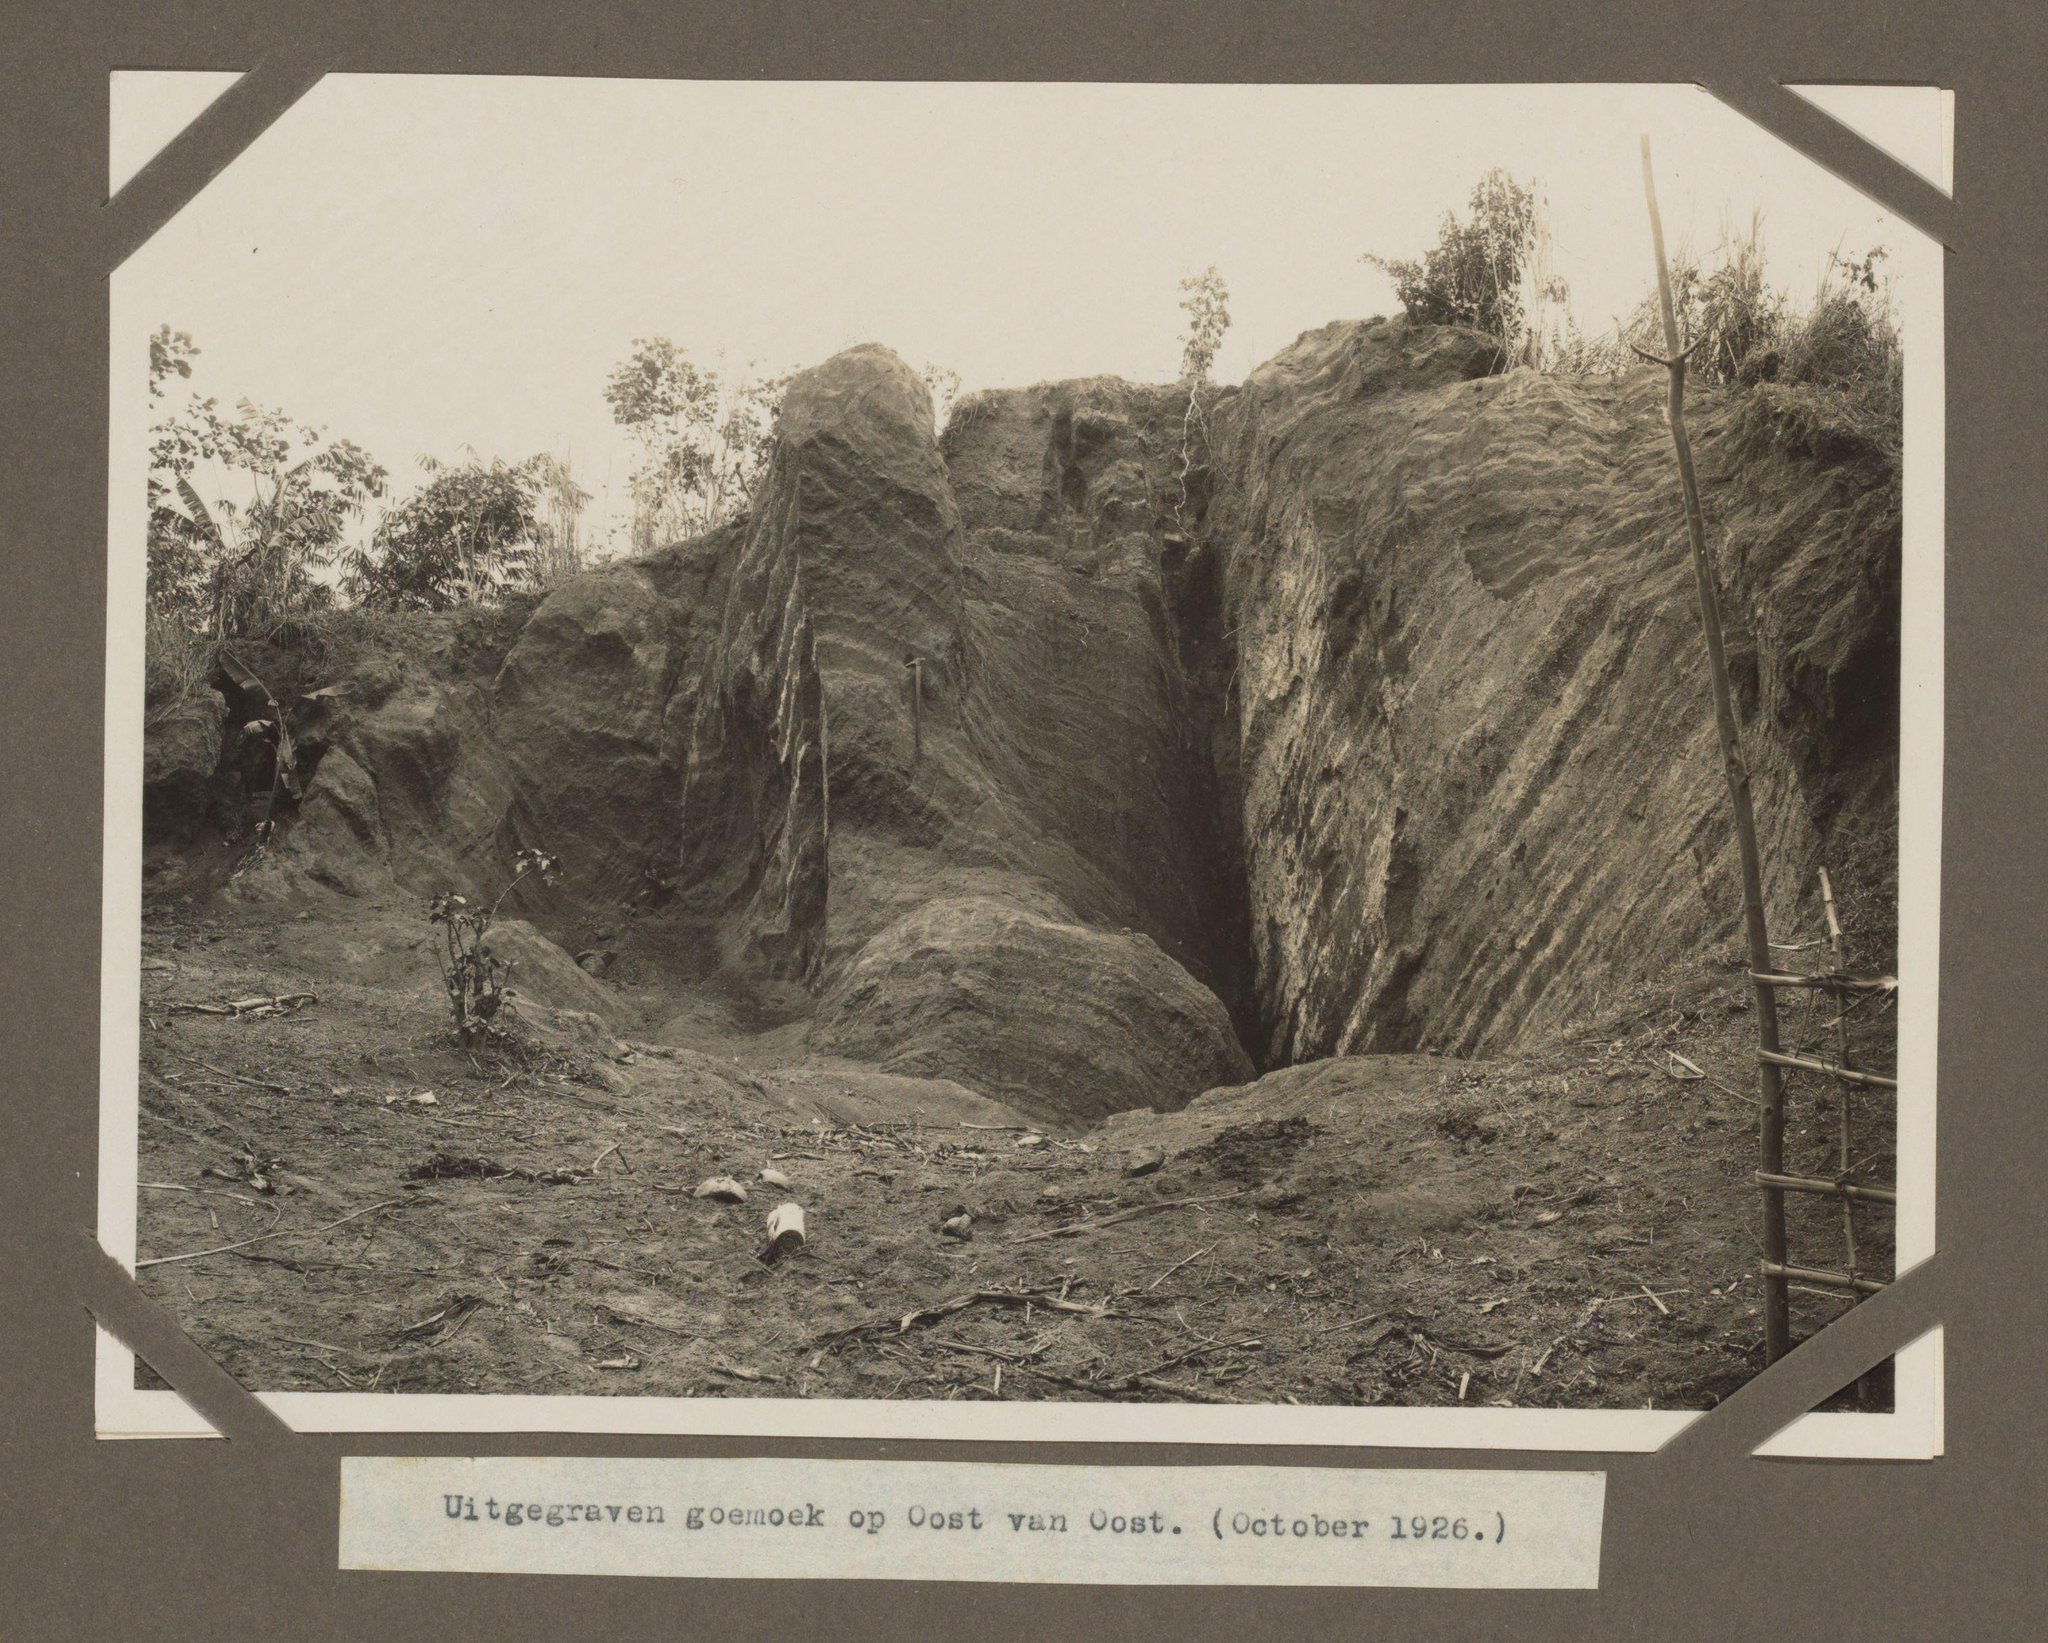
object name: photograph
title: Uitgegraven goemoek op Oost van Oost. (October 1926.)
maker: Anonymous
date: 1910-1926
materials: photographic support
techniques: gelatin silver print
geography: east java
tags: colonial system, trade-company, (non-fruit) products of plants or trees: sugarcane, building-site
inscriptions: inscription: ‘Uitgegraven goemoek op Oost van Oost. (October 1926.)’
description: Gezicht op deels uitgegraven versteningen in de aarden heuvel (goemoek) op Oost van Oost, waarschijnlijk gelegen op het fabrieksterrein, oktober 1926. Onderdeel van het fotoalbum met foto's van de opbouw van de suikerfabriek te Goenoengsari op Oost-Java door de Handels Vereniging Amsterdam 1926-1927.